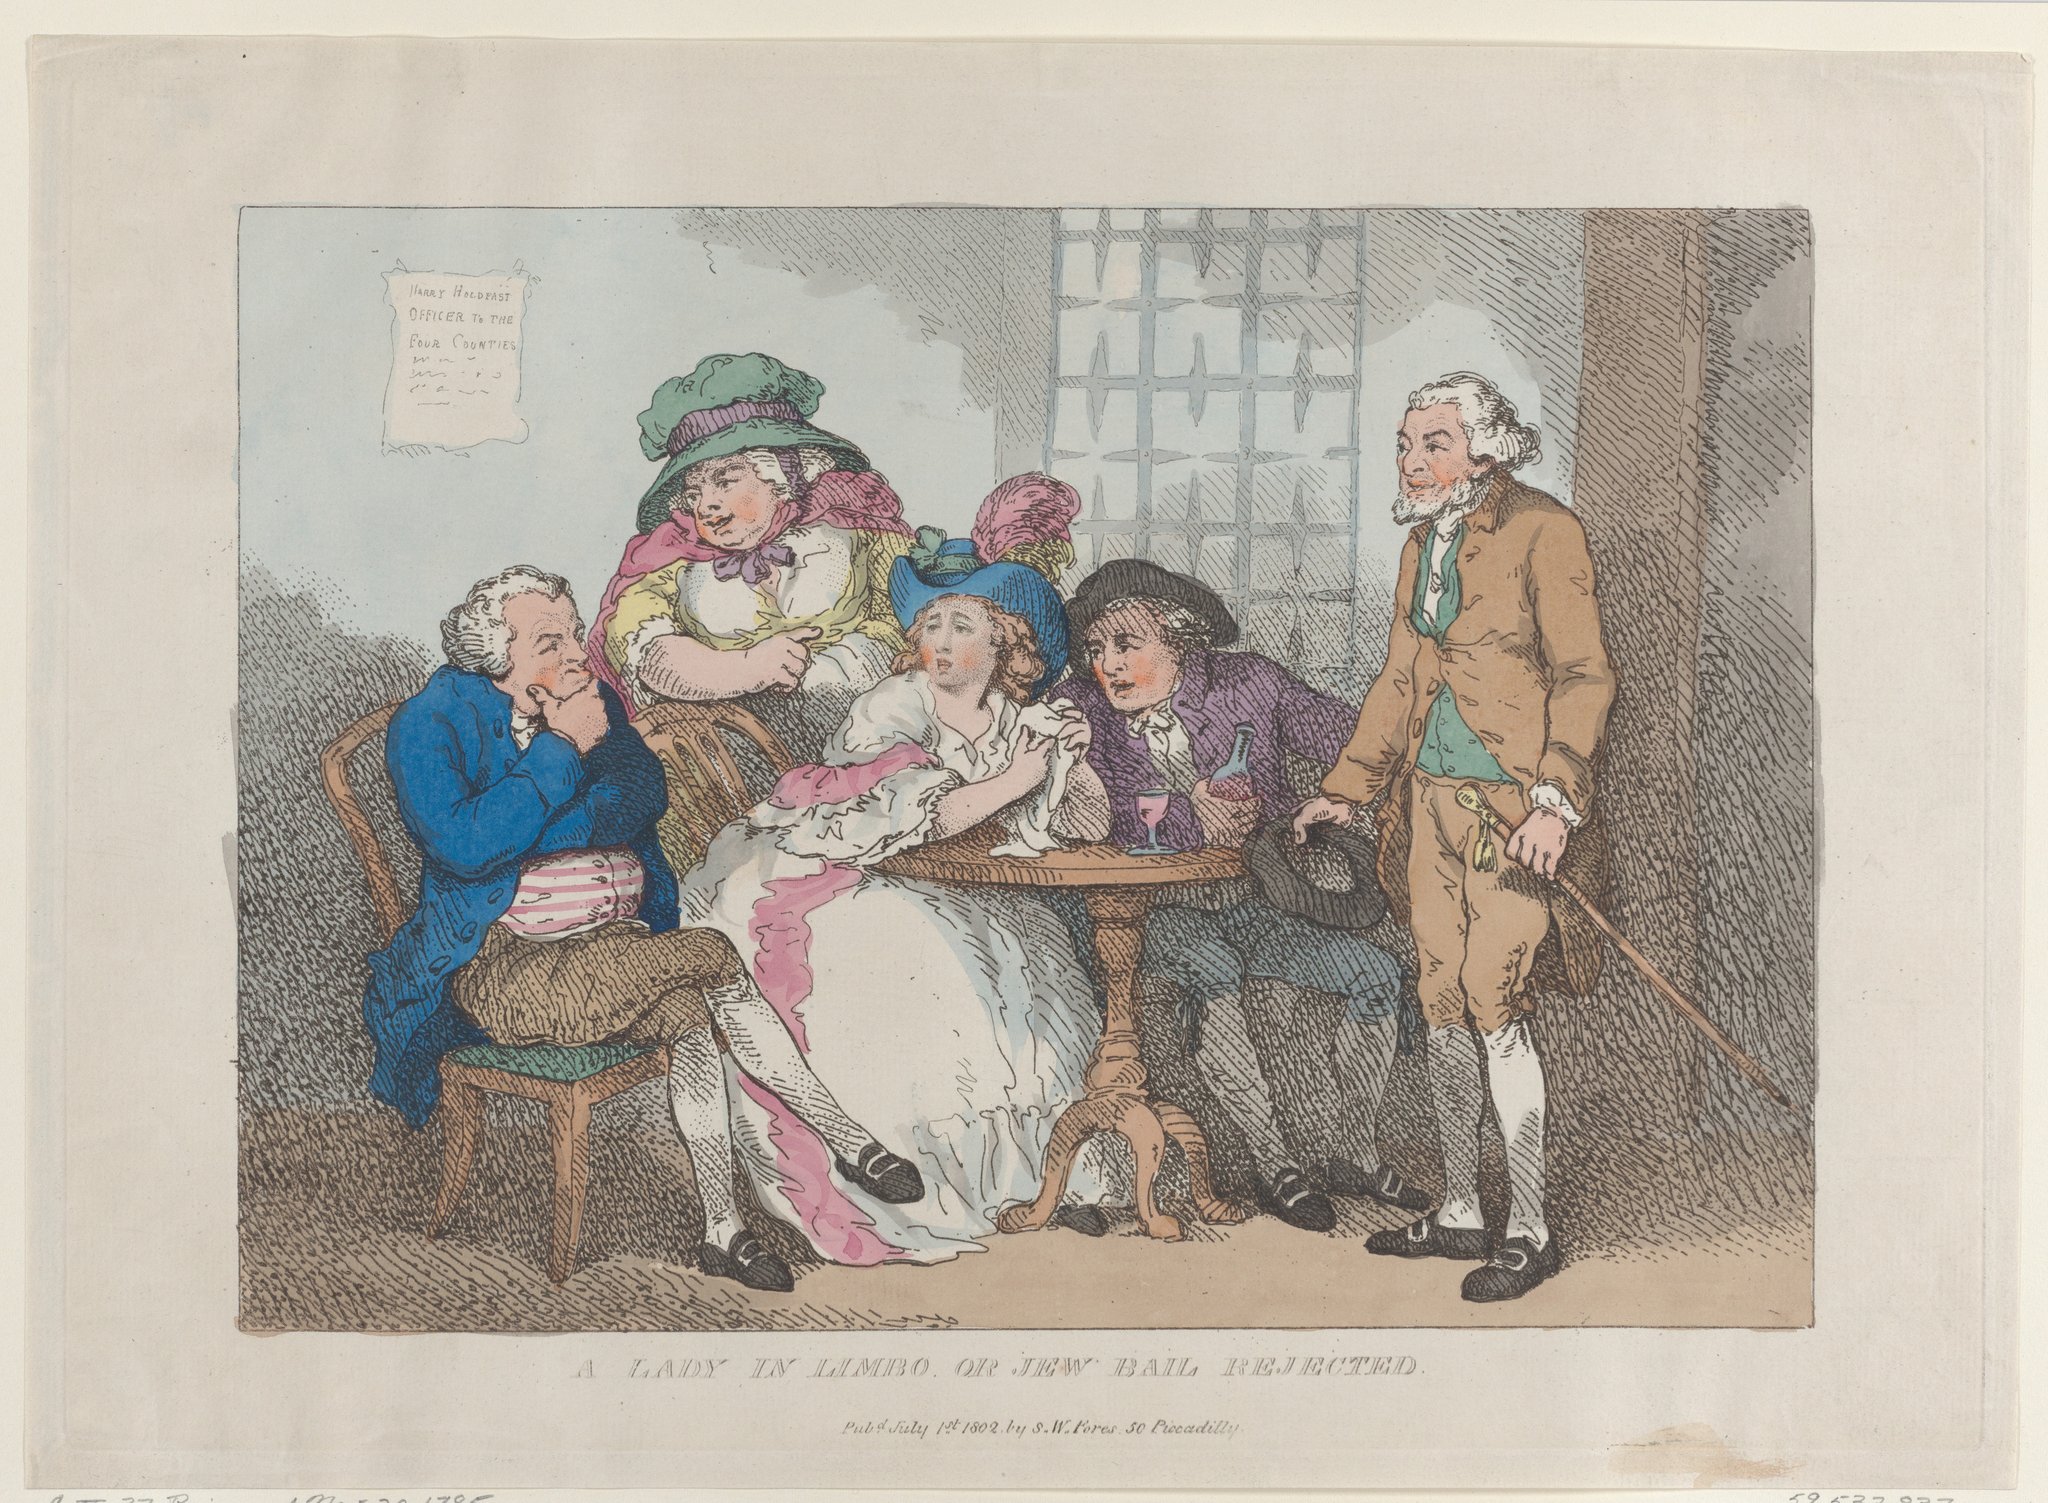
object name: print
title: A Lady in Limbo, or Jew Bail Rejected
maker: thomas rowlandson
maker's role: artist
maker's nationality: british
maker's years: 1757-1827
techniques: etching, stippling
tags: satire,men,women